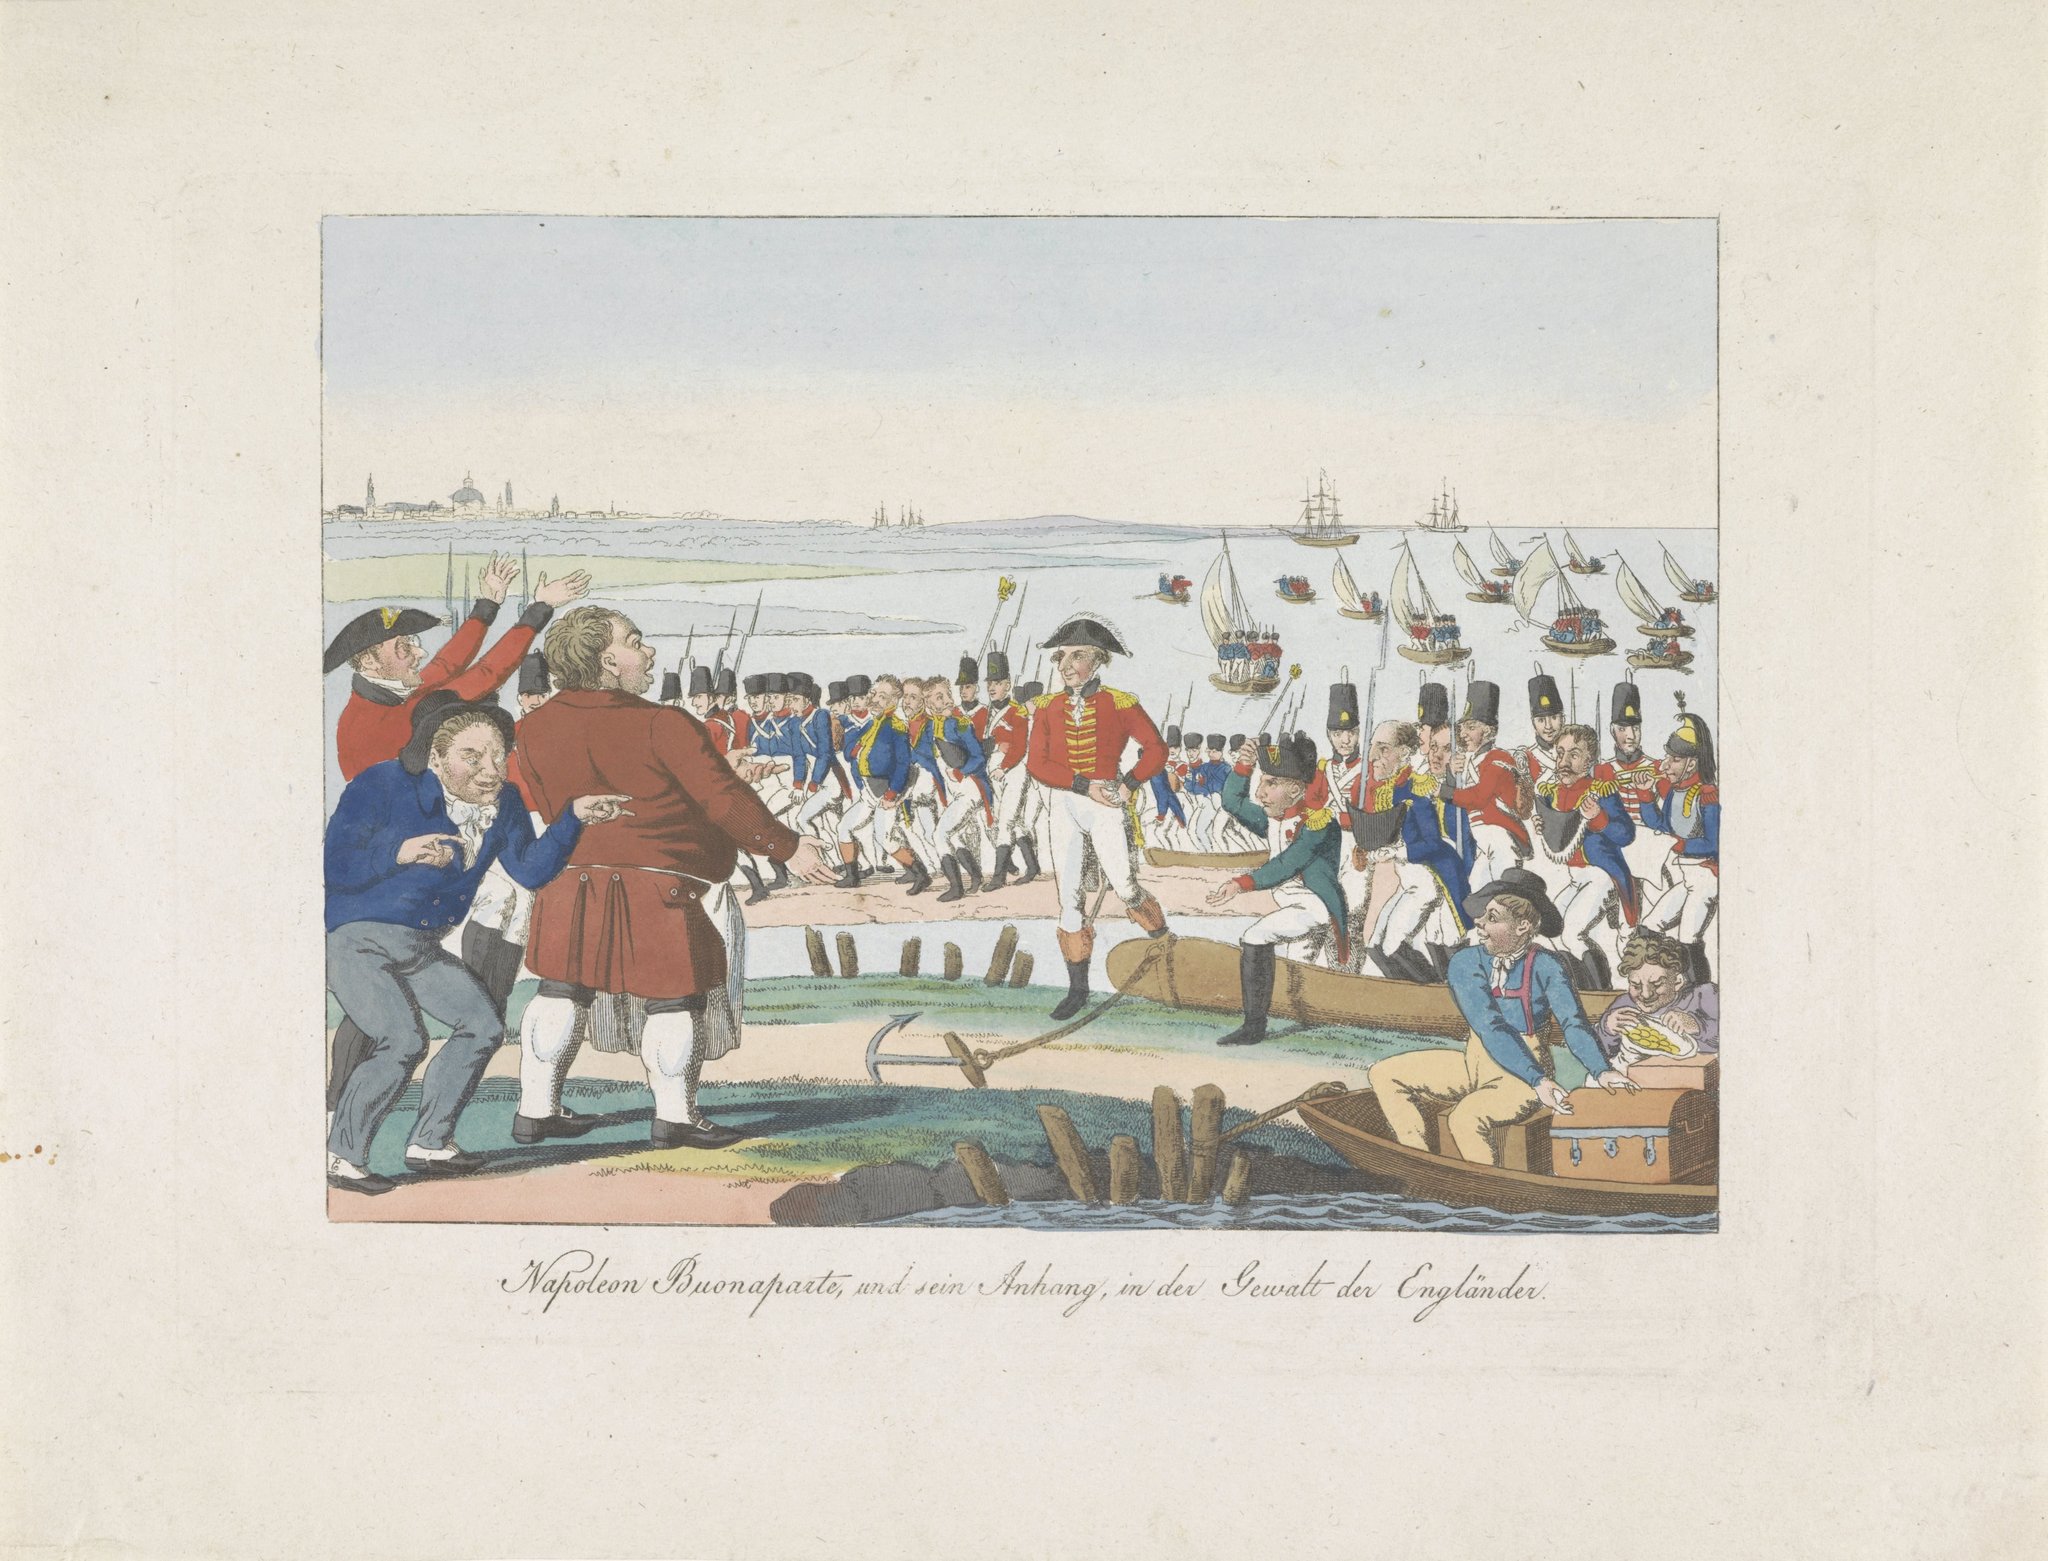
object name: print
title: Napoleon als gevangene in Engeland, ca. 1814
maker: Anonymous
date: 1814-1815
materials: paper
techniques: etching, hand coloring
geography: germany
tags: napoleon i (emperor of the french), arrest of fleeing ruler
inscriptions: collector's mark: Lugt 2228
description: Spotprent op Napoleon waarin is te zien hoe Napoleon en zijn Franse troepen als gevangenen van Britse soldaten in Engeland aan land worden gebracht. Op land worden zij opgewacht door lachende Engelsen. Spotprent op de val van Napoleon, ca. 1814-1815.